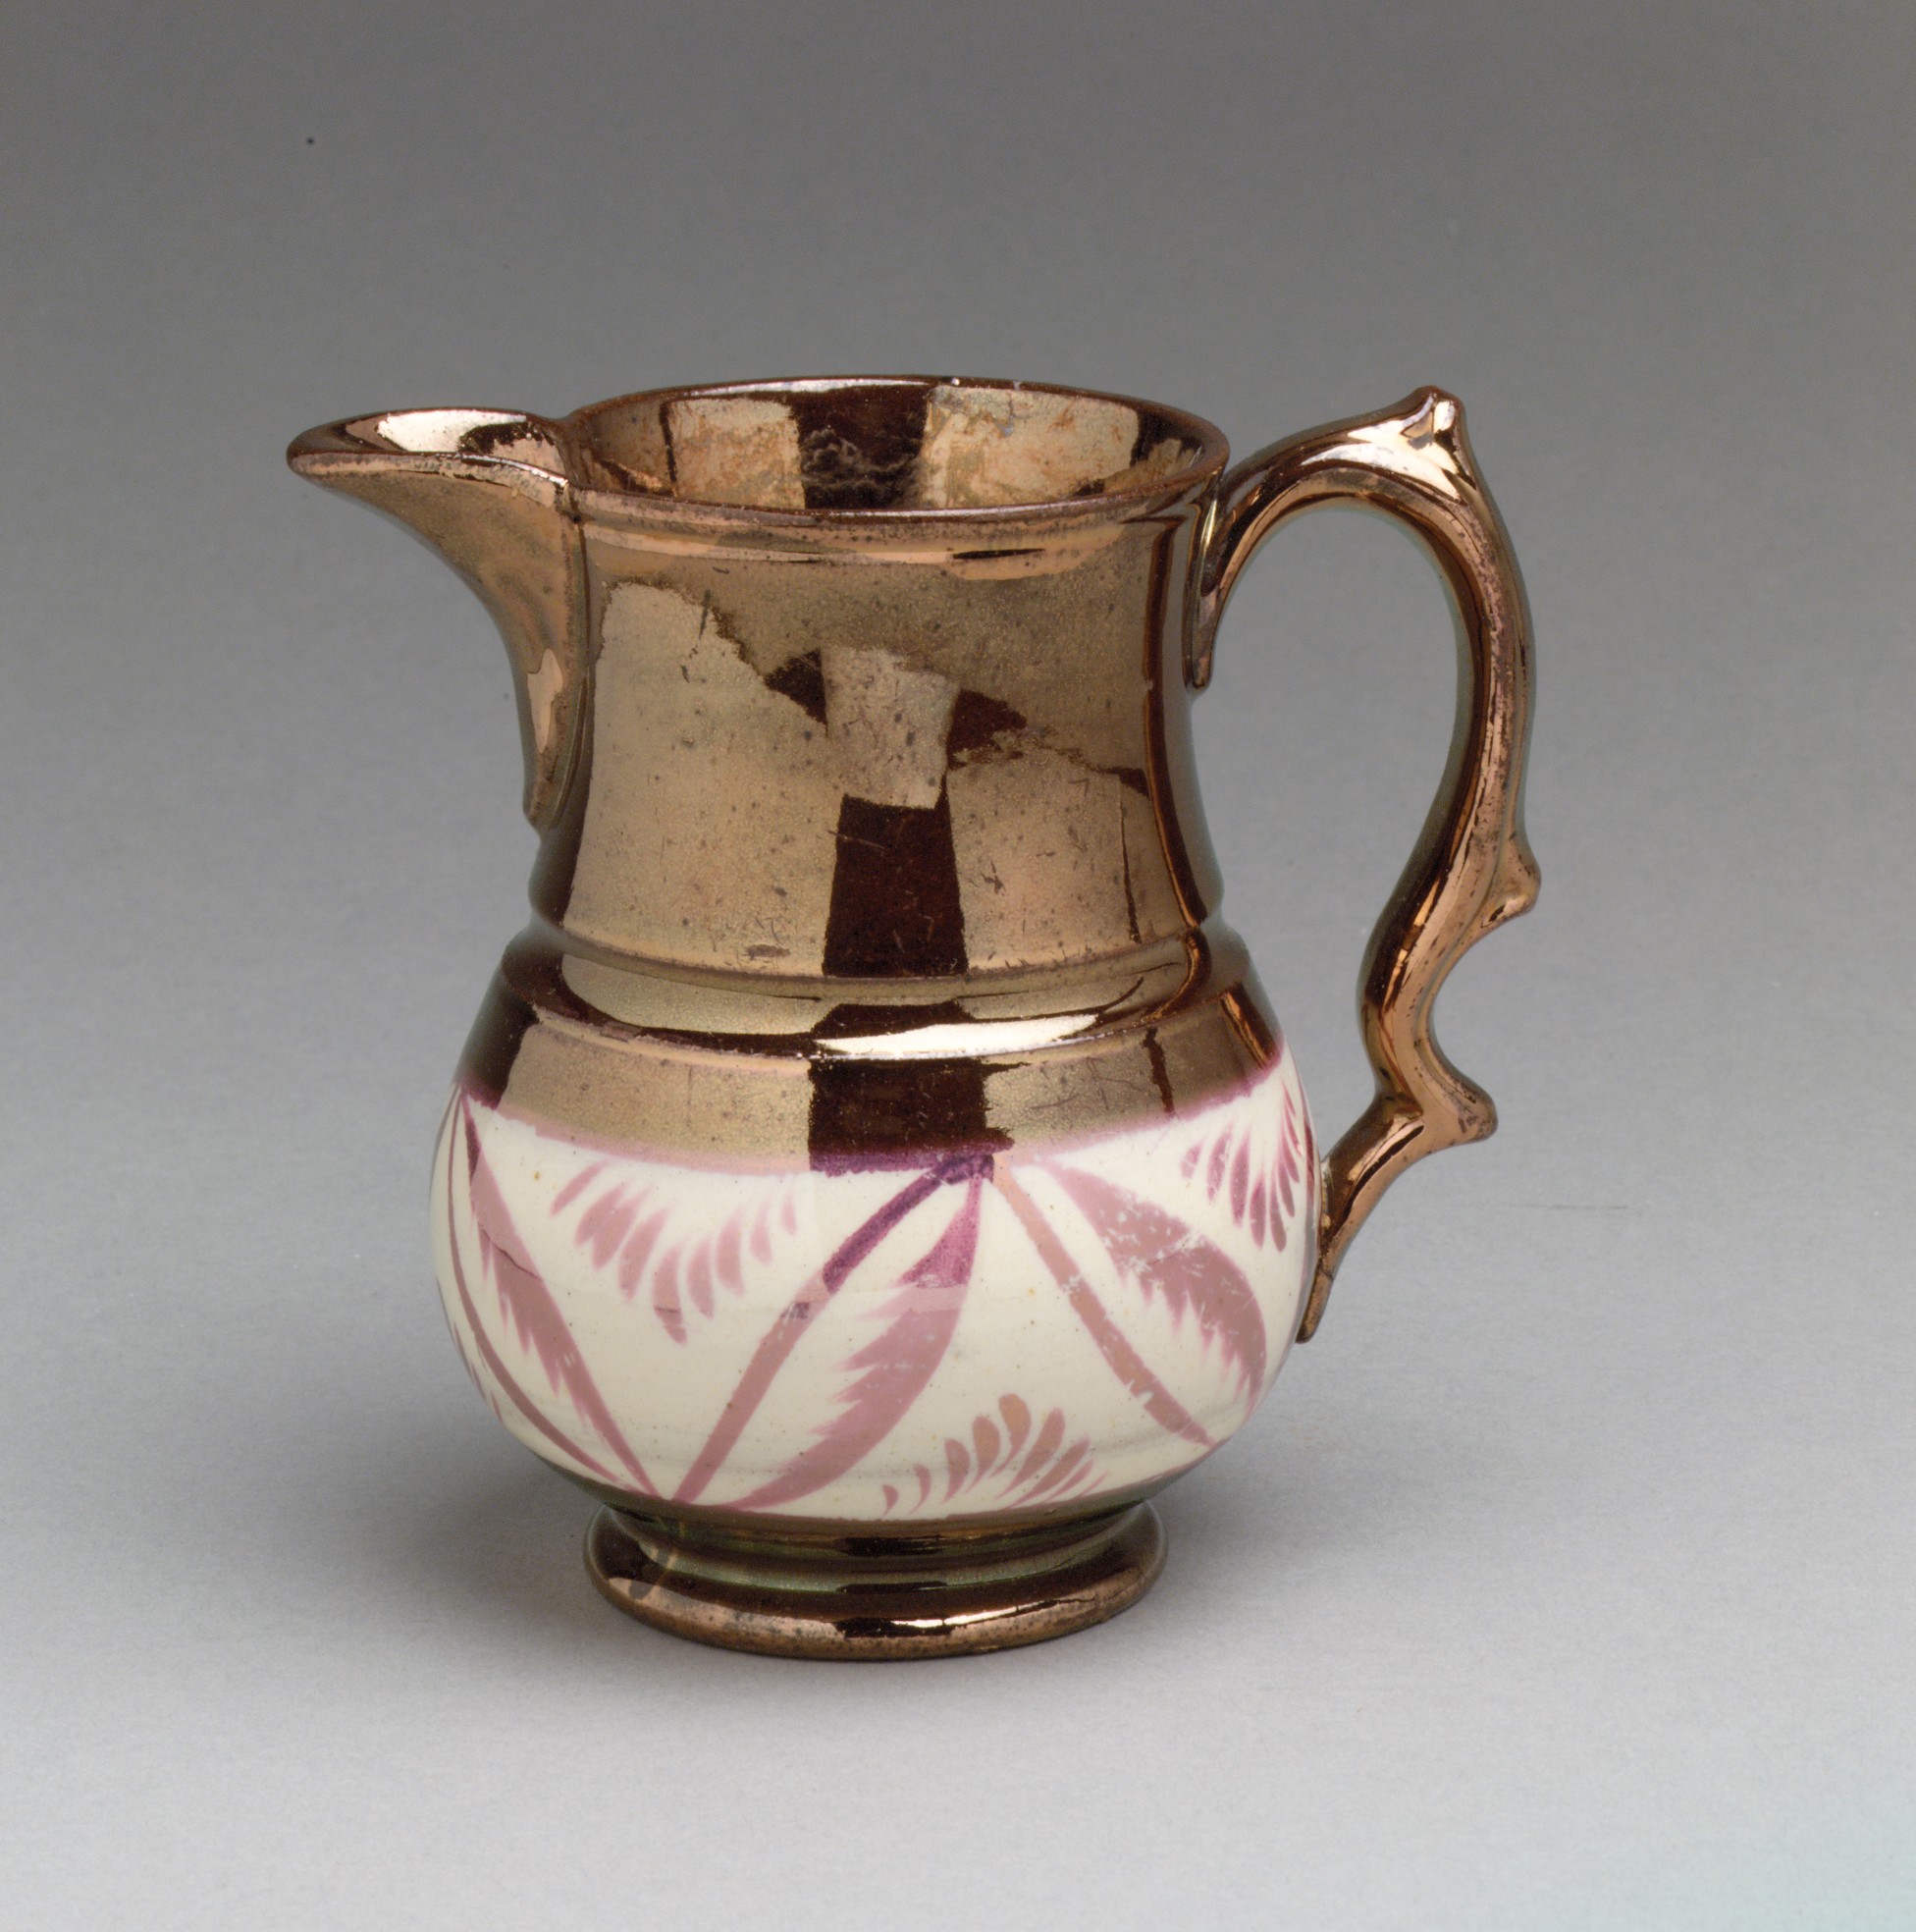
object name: pitcher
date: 1801-1900